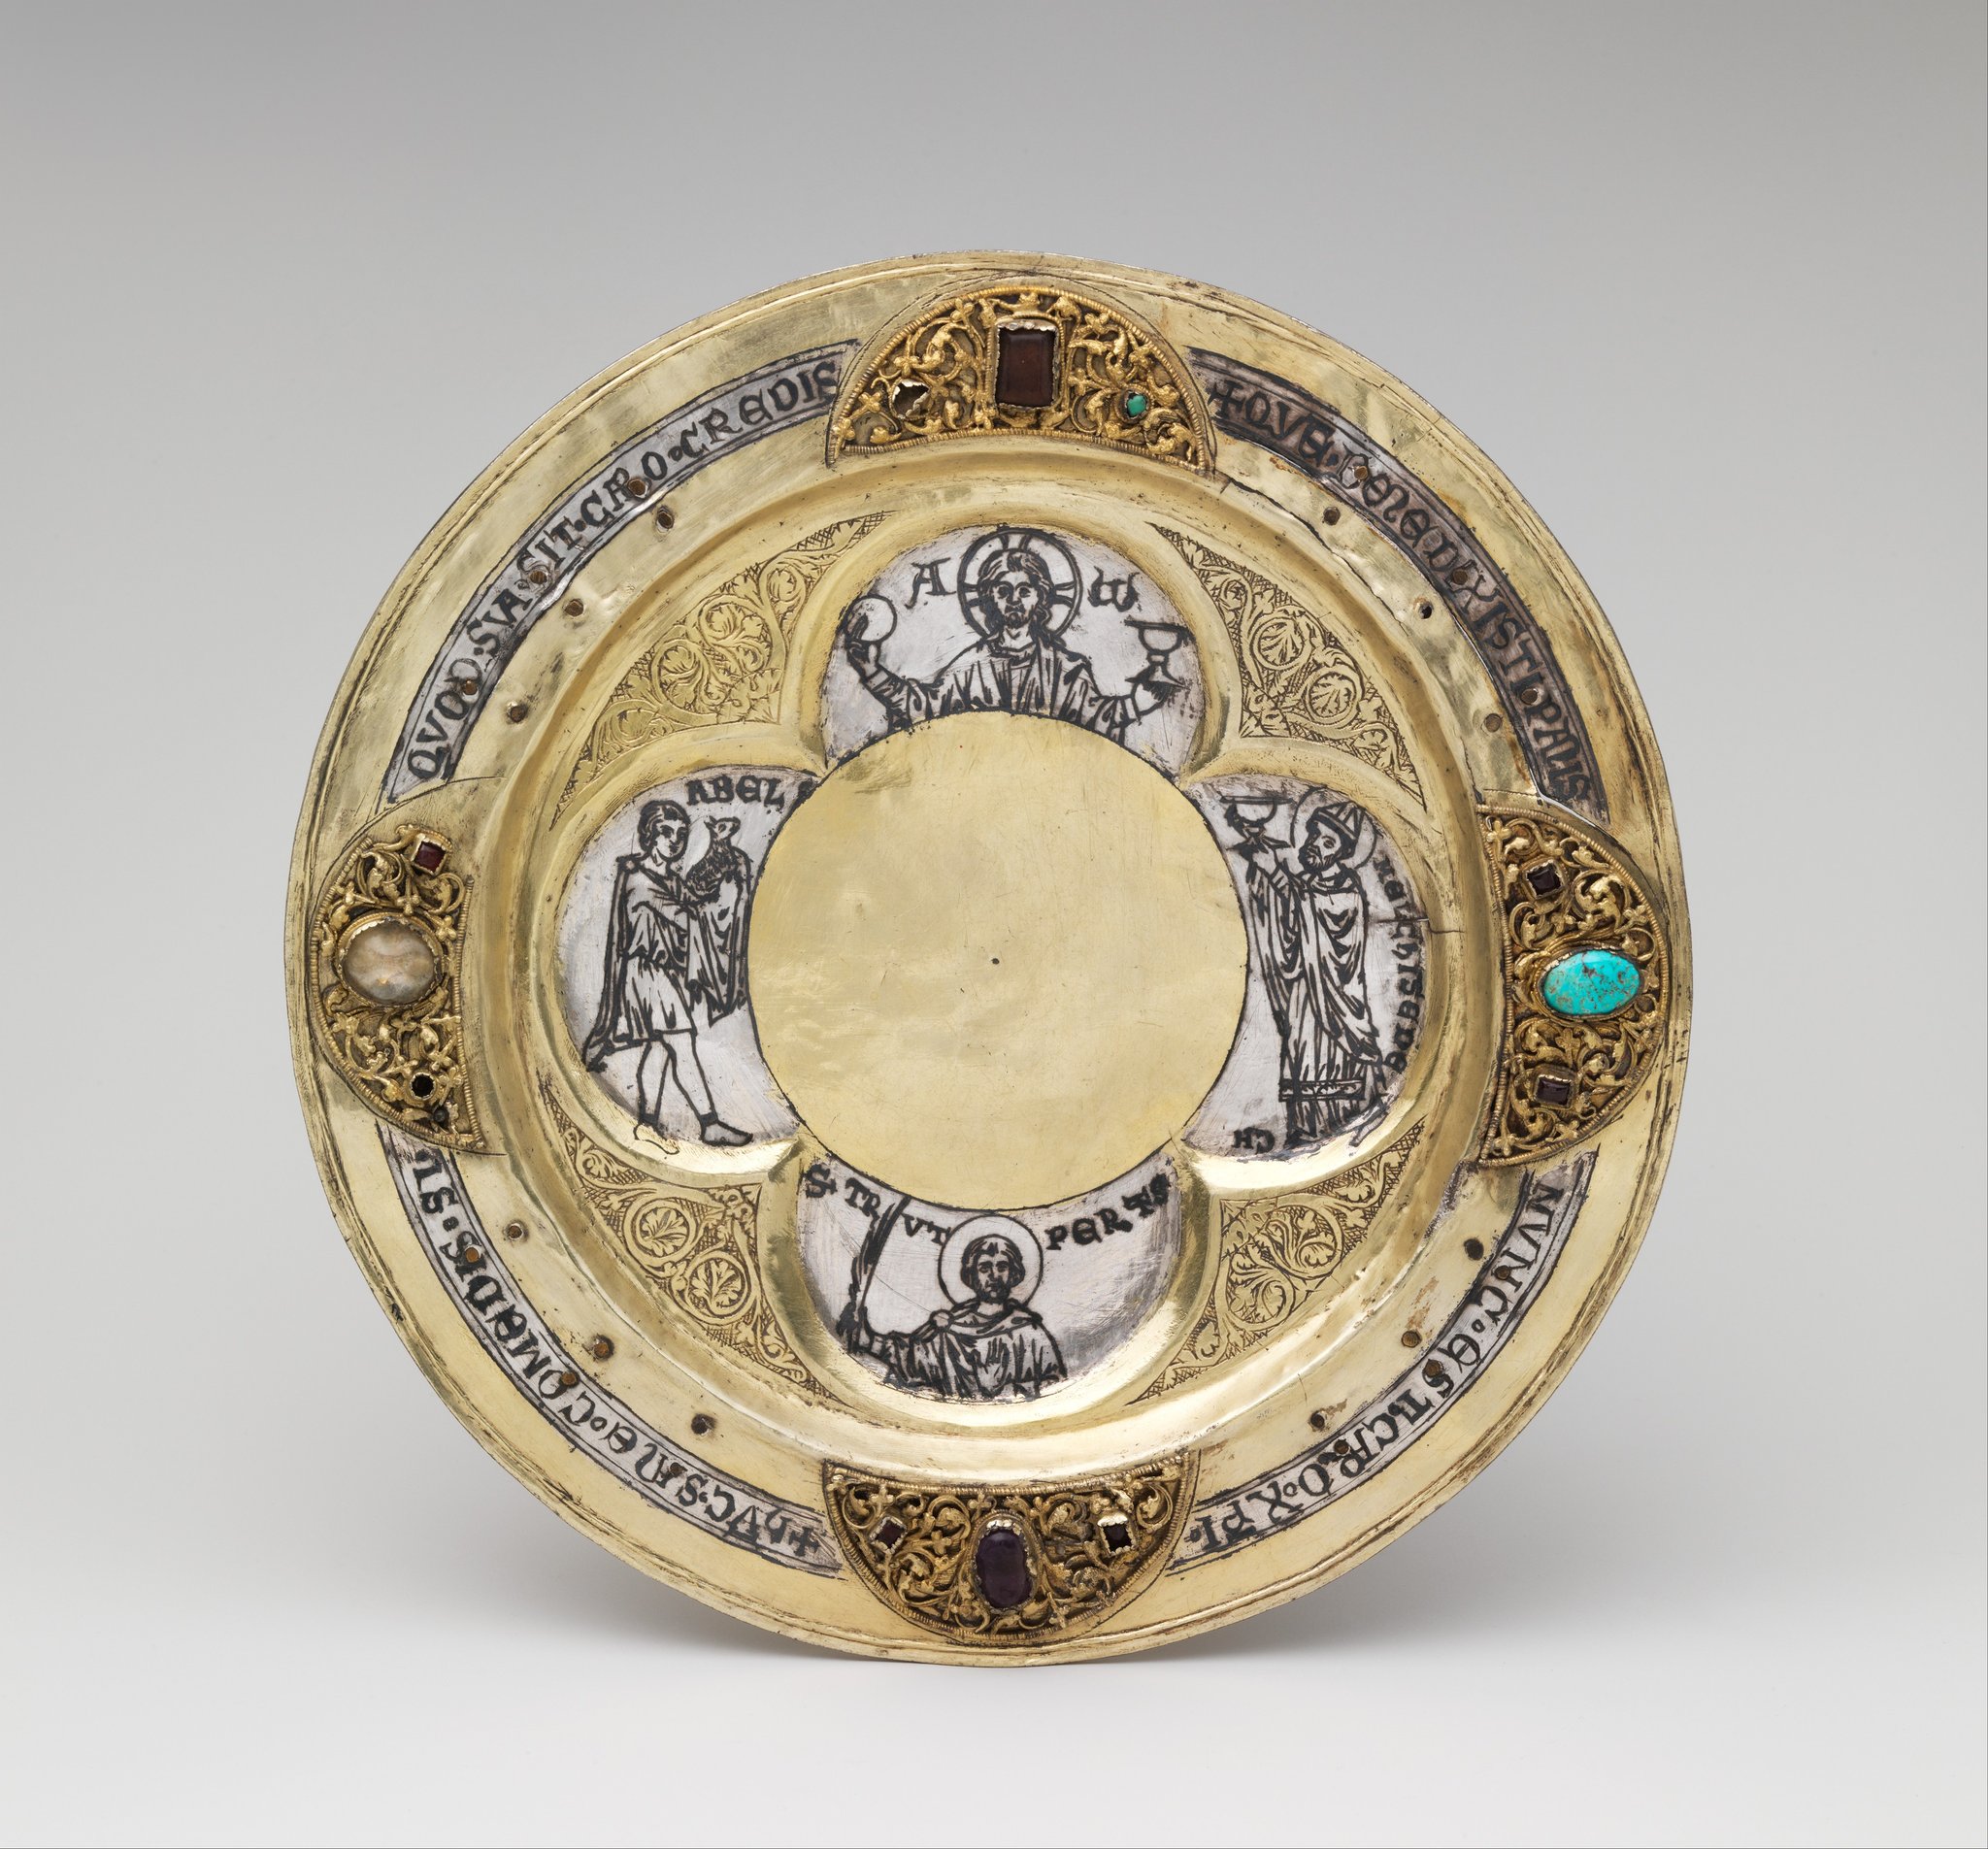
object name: paten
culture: german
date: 1230-1250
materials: gilt, niello, silver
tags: christ,abel,saints